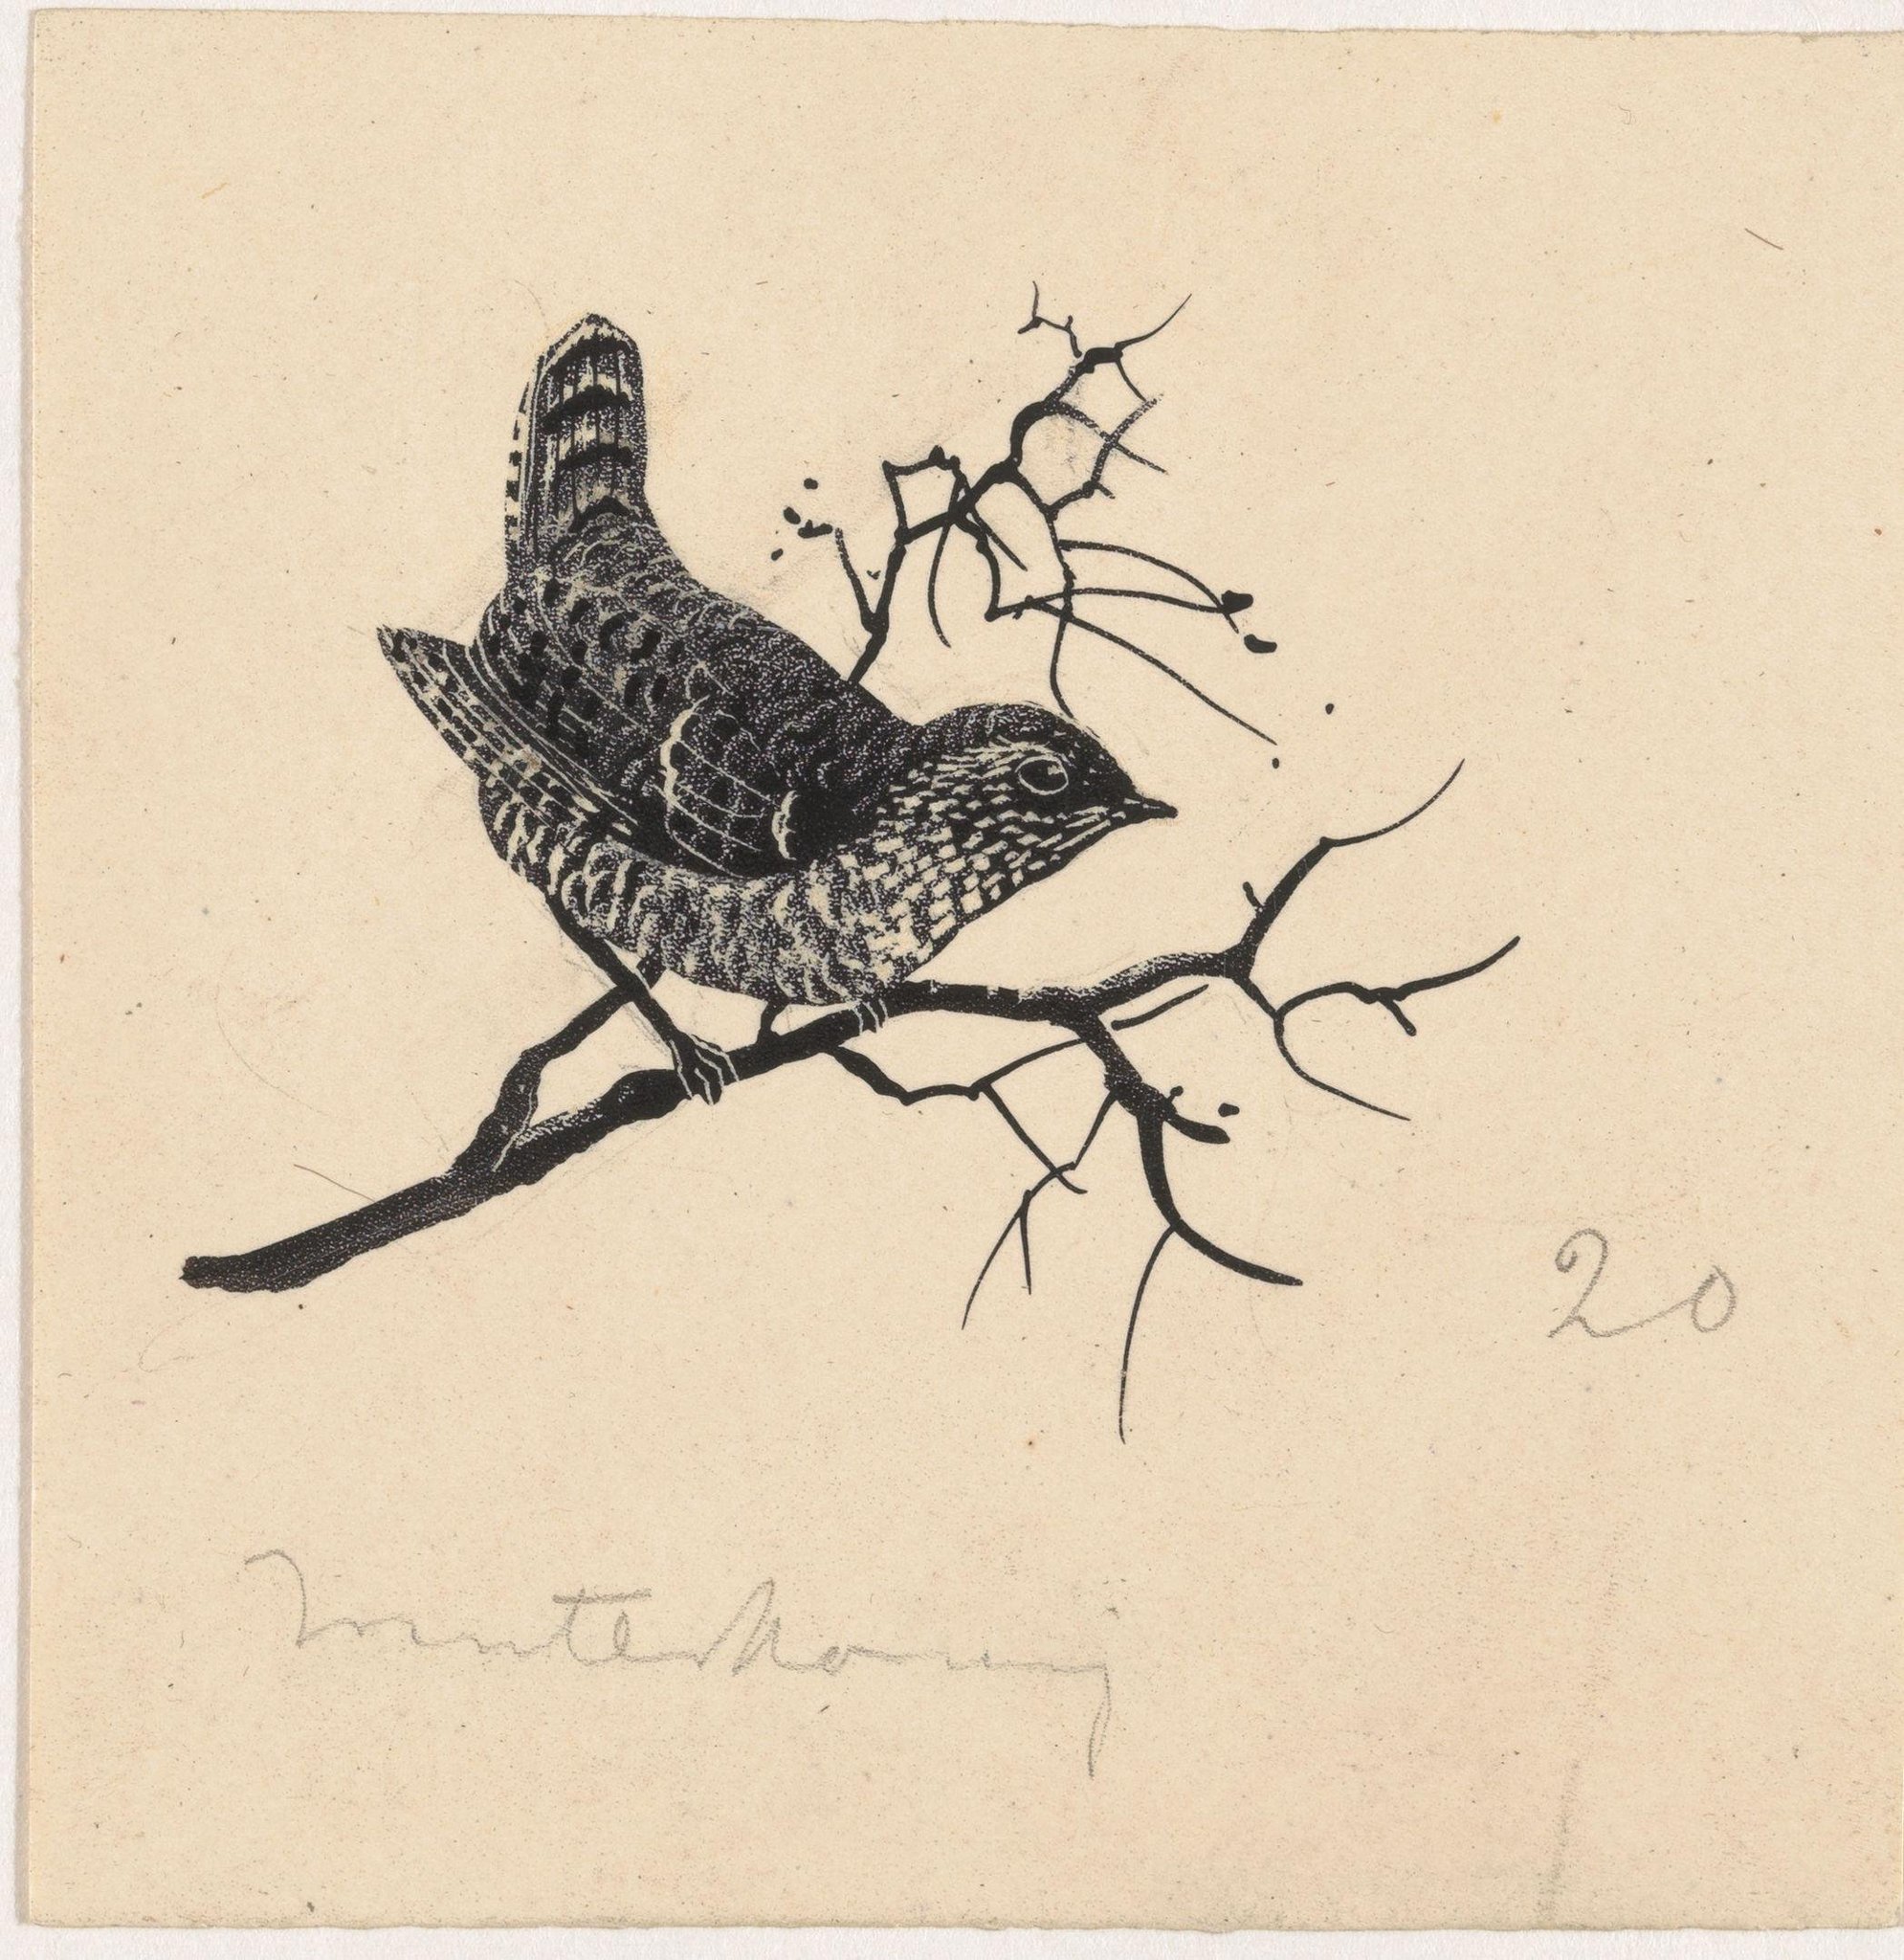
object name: drawing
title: Winterkoning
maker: henri verstijnen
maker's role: draughtsman, print maker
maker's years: 1882-1940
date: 1892-1940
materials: ink, paper, pencil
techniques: pen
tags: birds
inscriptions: collector's mark: Lugt 2228, annotation: ‘20/ Winterkoning’, annotation: ‘Lachende lente’, :